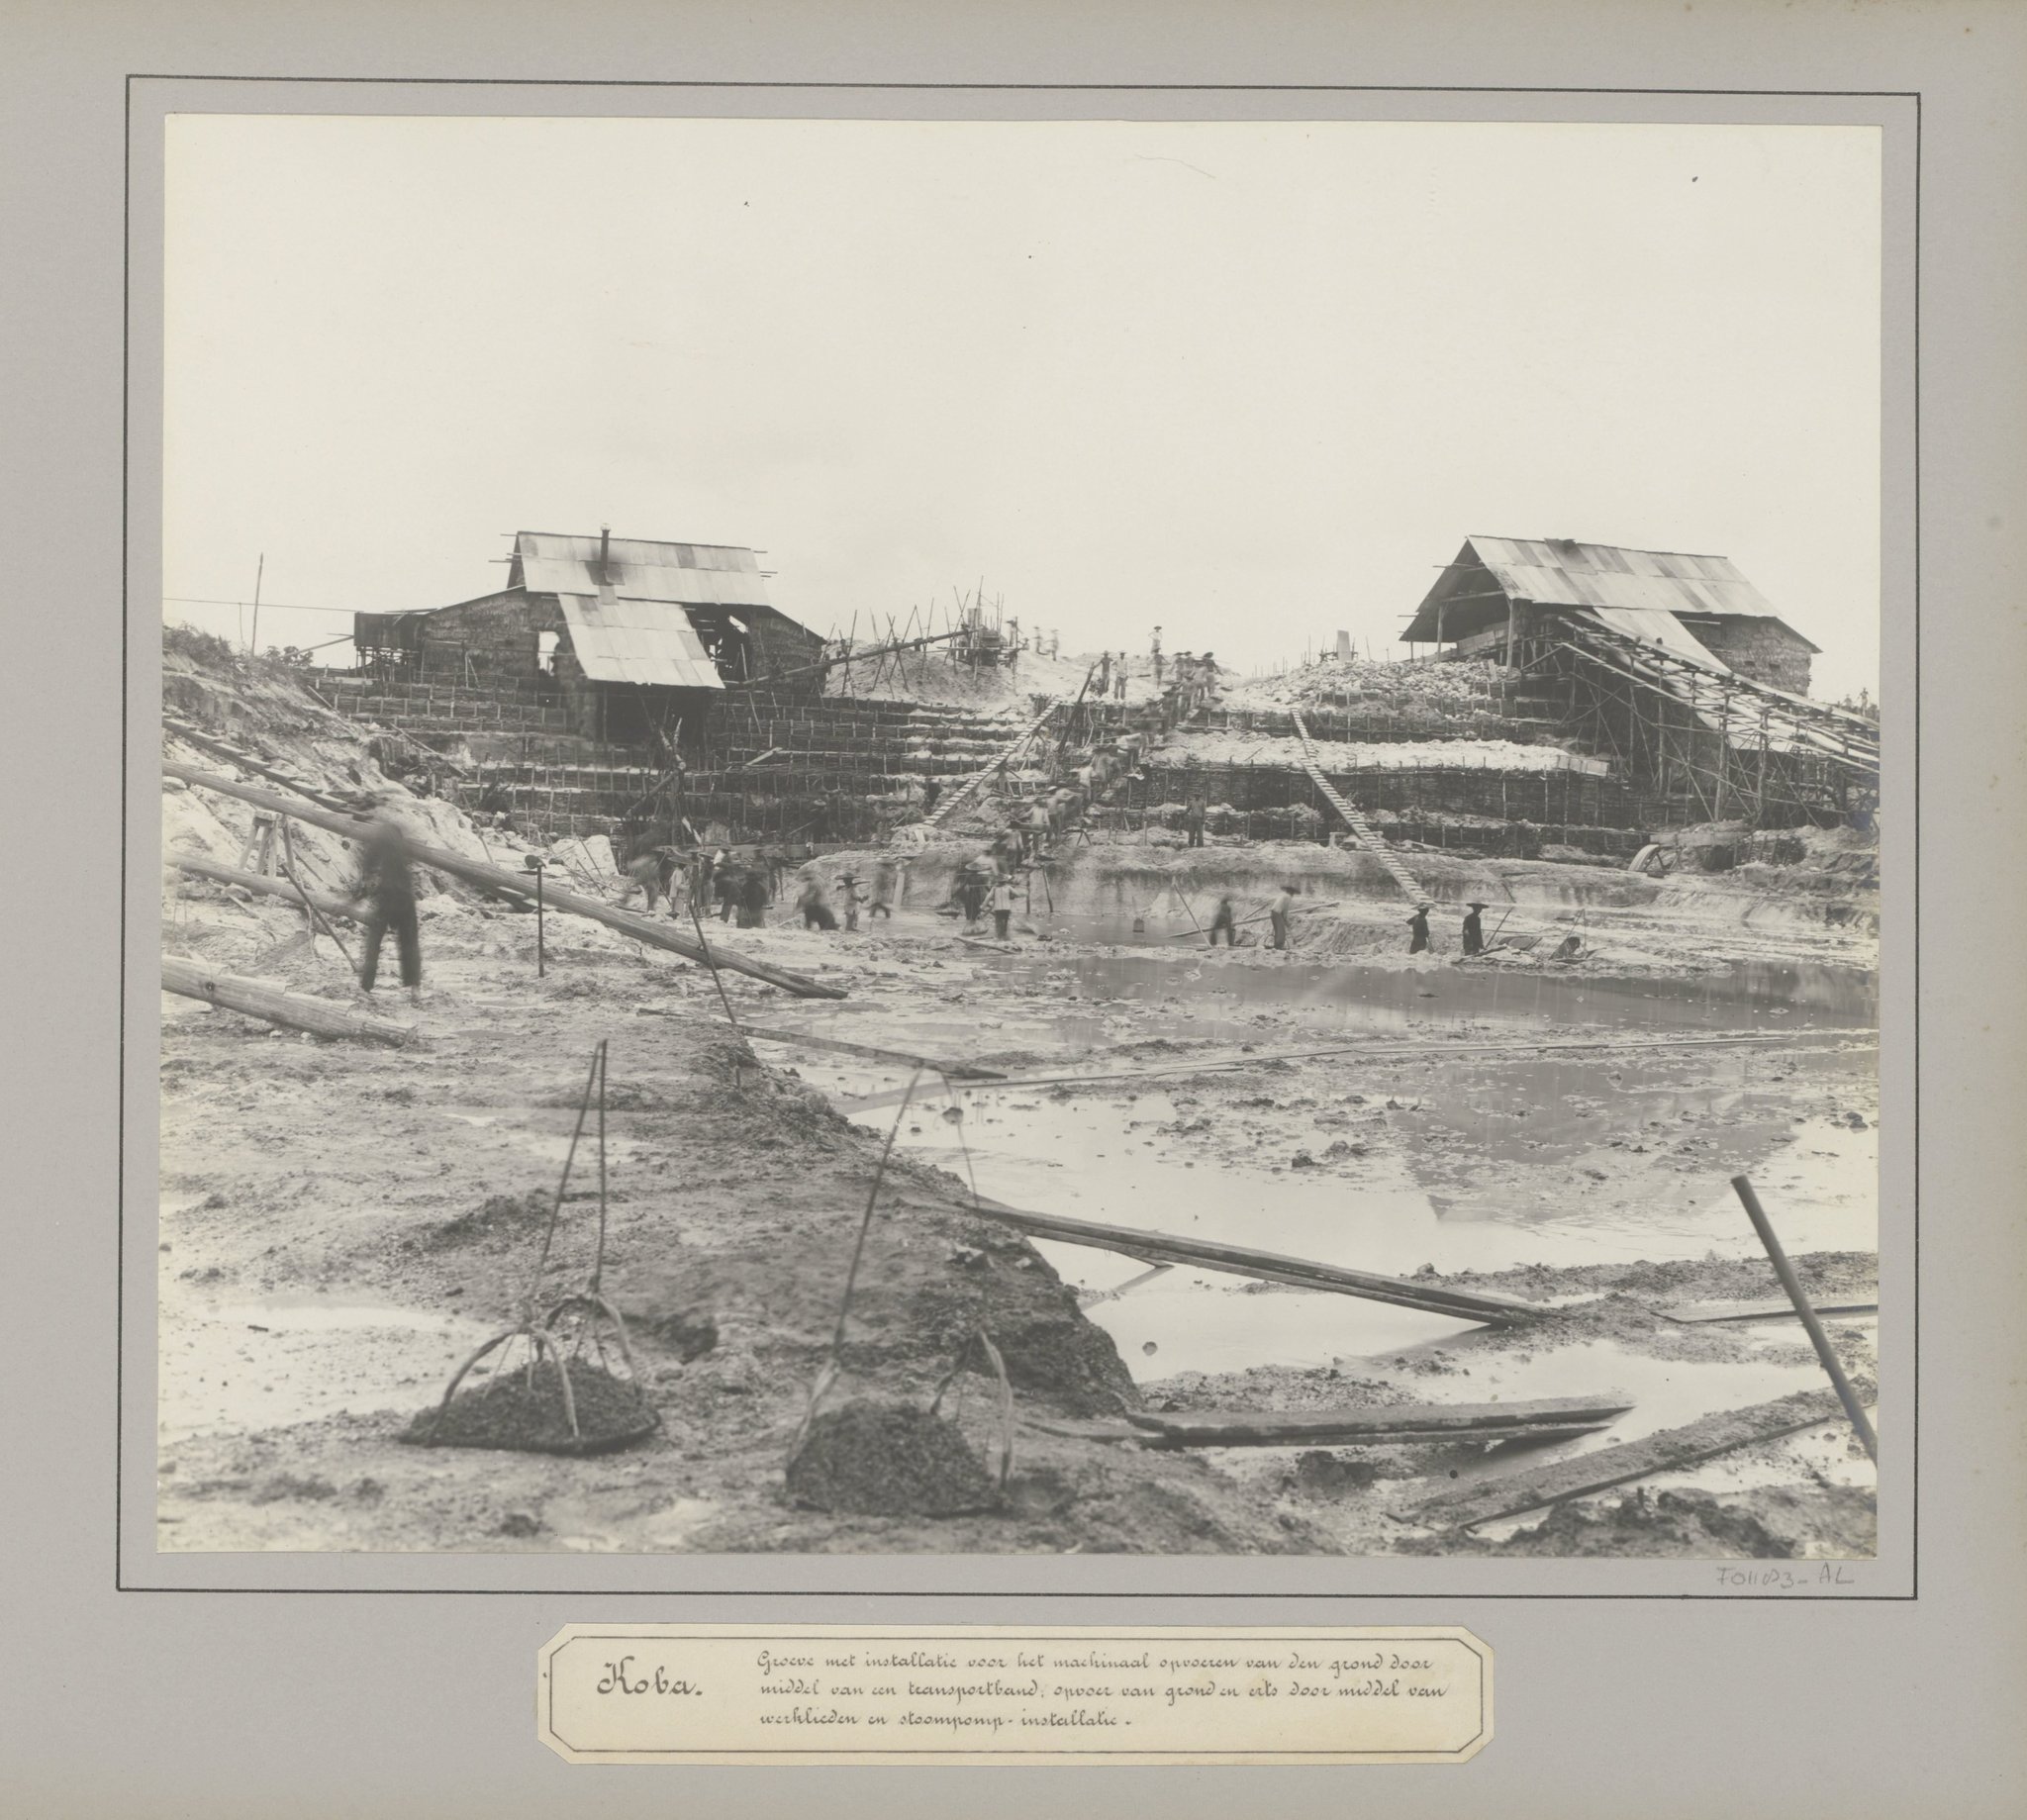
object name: photograph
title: Koba. Groeve met installatie voor het machinaal opvoeren van den grond door middel van een transportband; opvoer van grond en erts door middel van werklieden en stoompomp-installatie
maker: Anonymous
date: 1900-1920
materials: photographic support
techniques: gelatin silver print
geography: koba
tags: mining, minerals and metals: tin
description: Onderdeel van Fotoalbum over de tinwinning op Bangka.